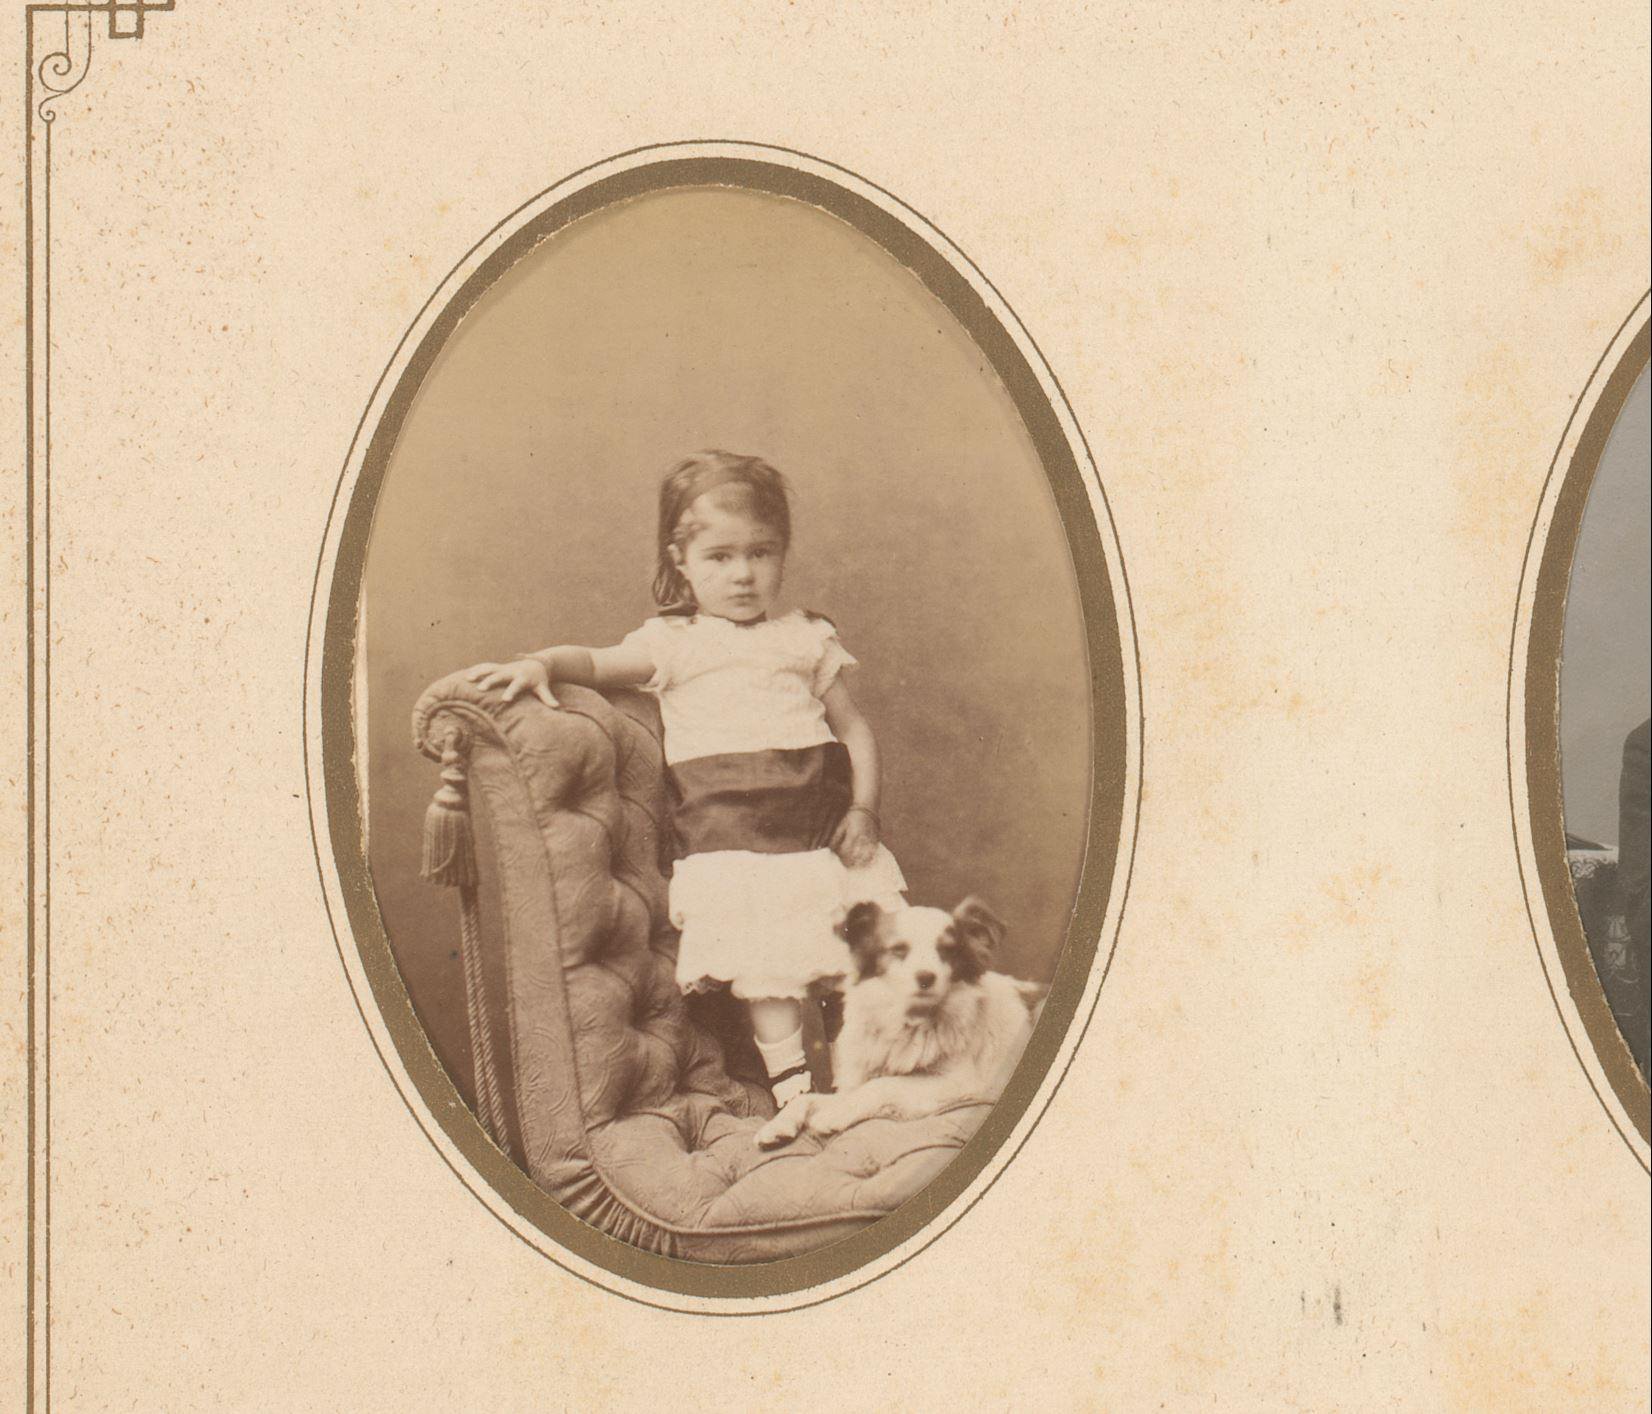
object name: album leaf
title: Portret van een meisje en hond op een fauteuil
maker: jan goedeljee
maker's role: fotograaf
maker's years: 1824-1905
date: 1880-1883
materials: cardboard, photographic support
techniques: albumen print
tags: historical persons, girl (child between toddler and youth), dog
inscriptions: inscription: ‘J. Goedeljee/ Phototgraaf/(...)/ Leiden/ Hoogewoerd 160’